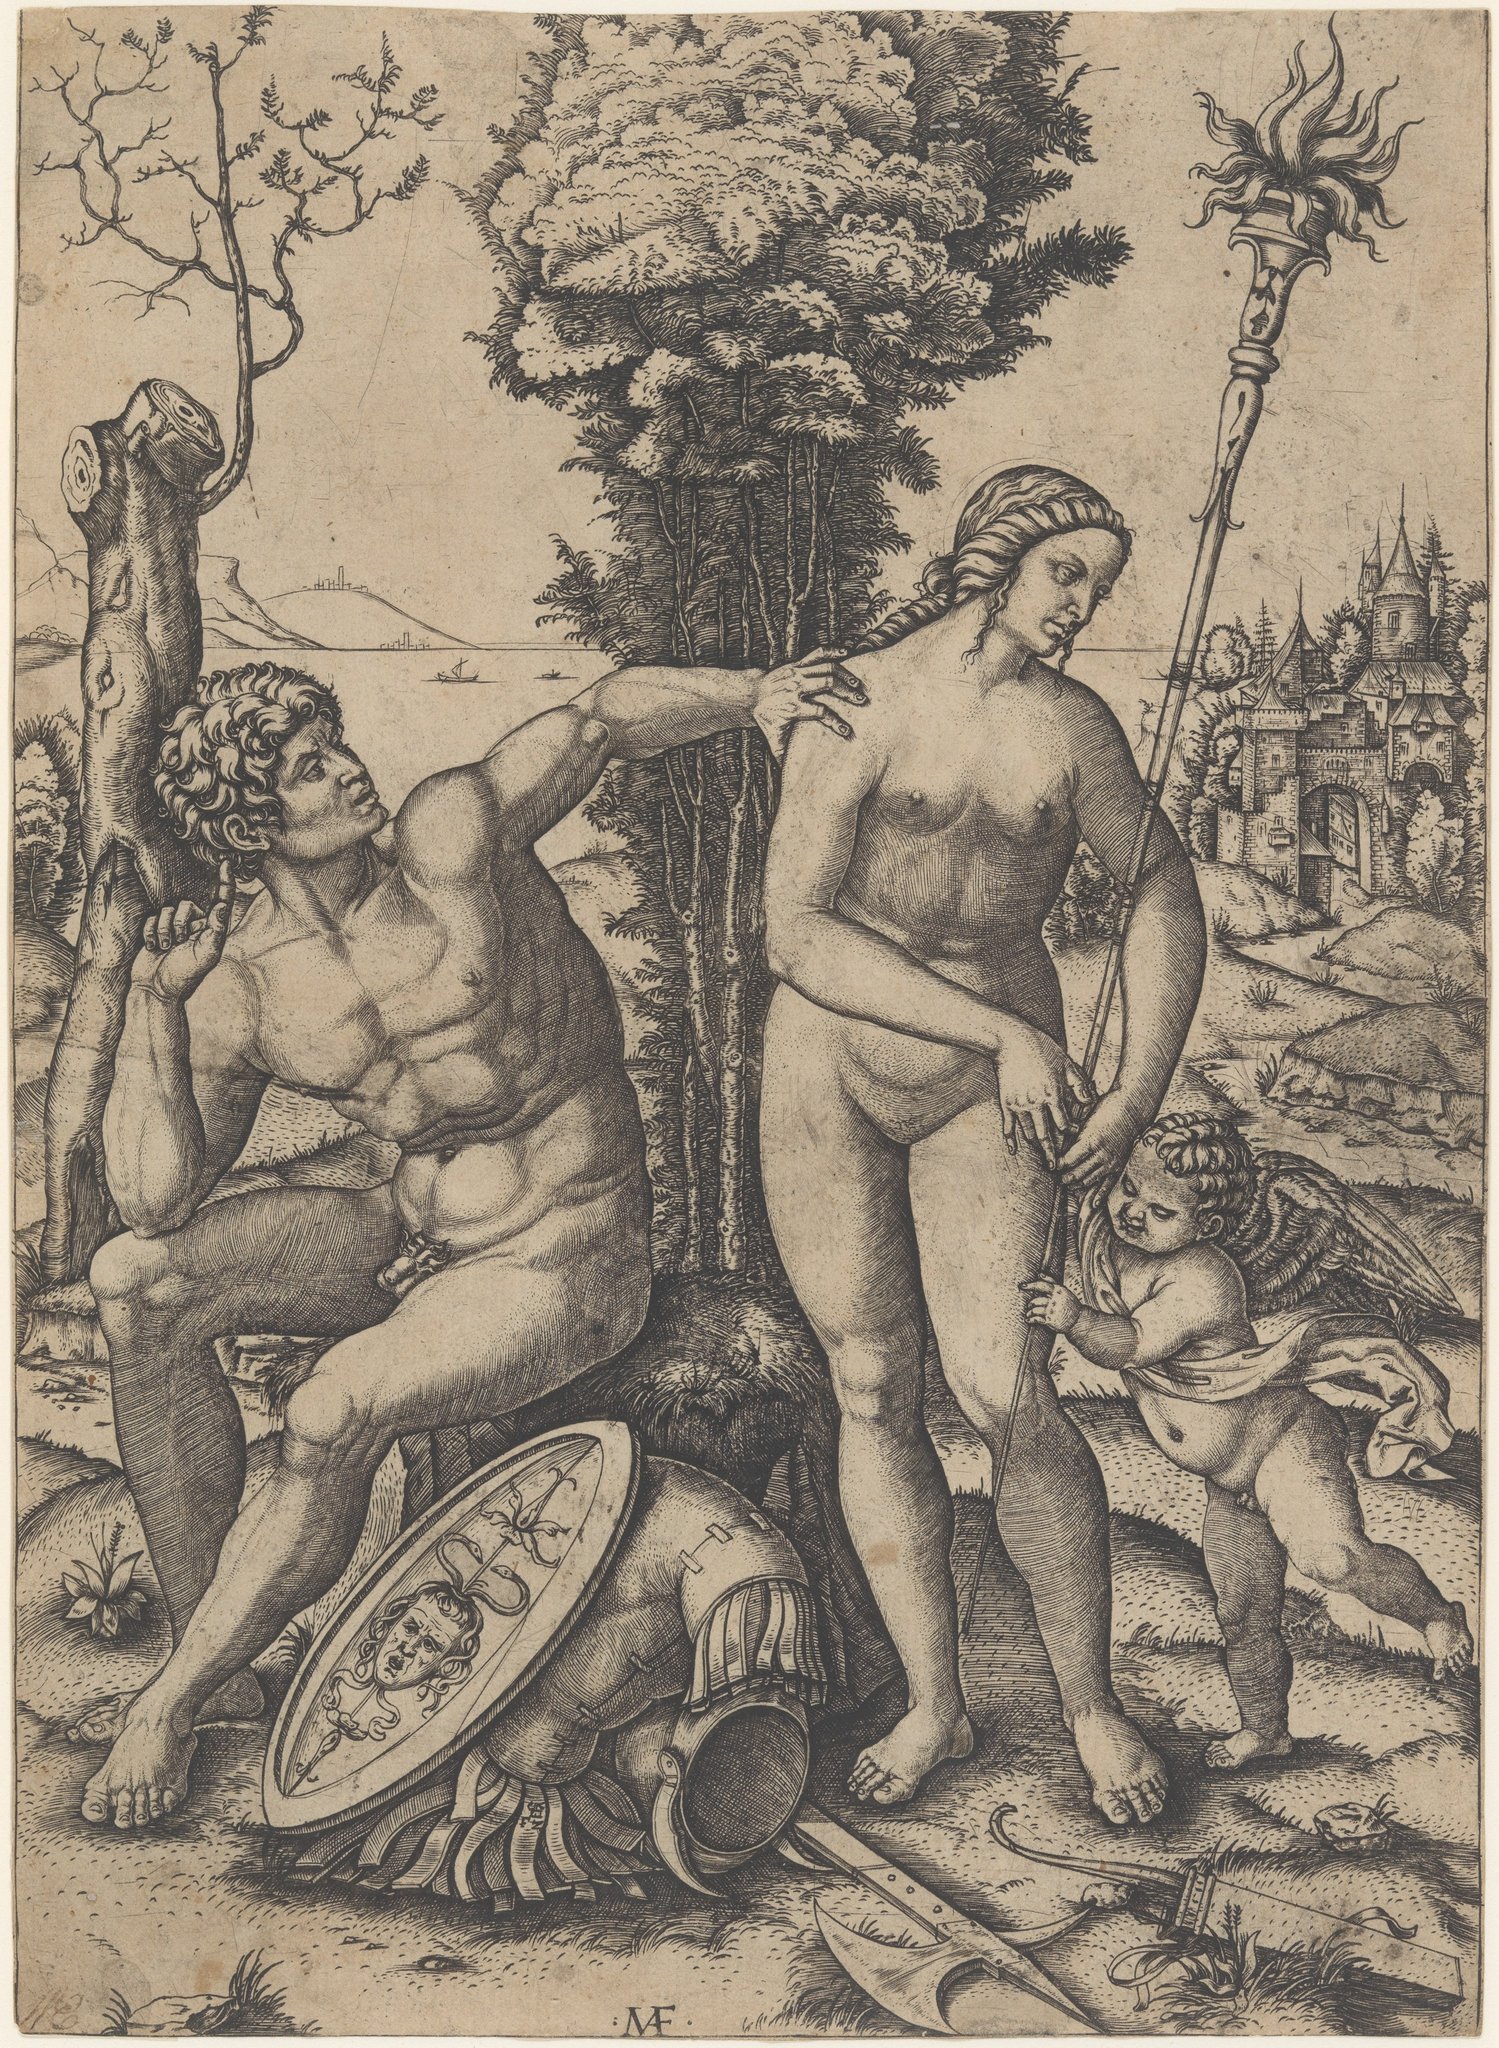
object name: print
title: Mars seated at the left, his left hand on Venus's shoulder, cupid beside her at the right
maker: marcantonio raimondi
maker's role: artist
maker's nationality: italian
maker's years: 1475-1534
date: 1508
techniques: engraving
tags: cupid,mars,venus